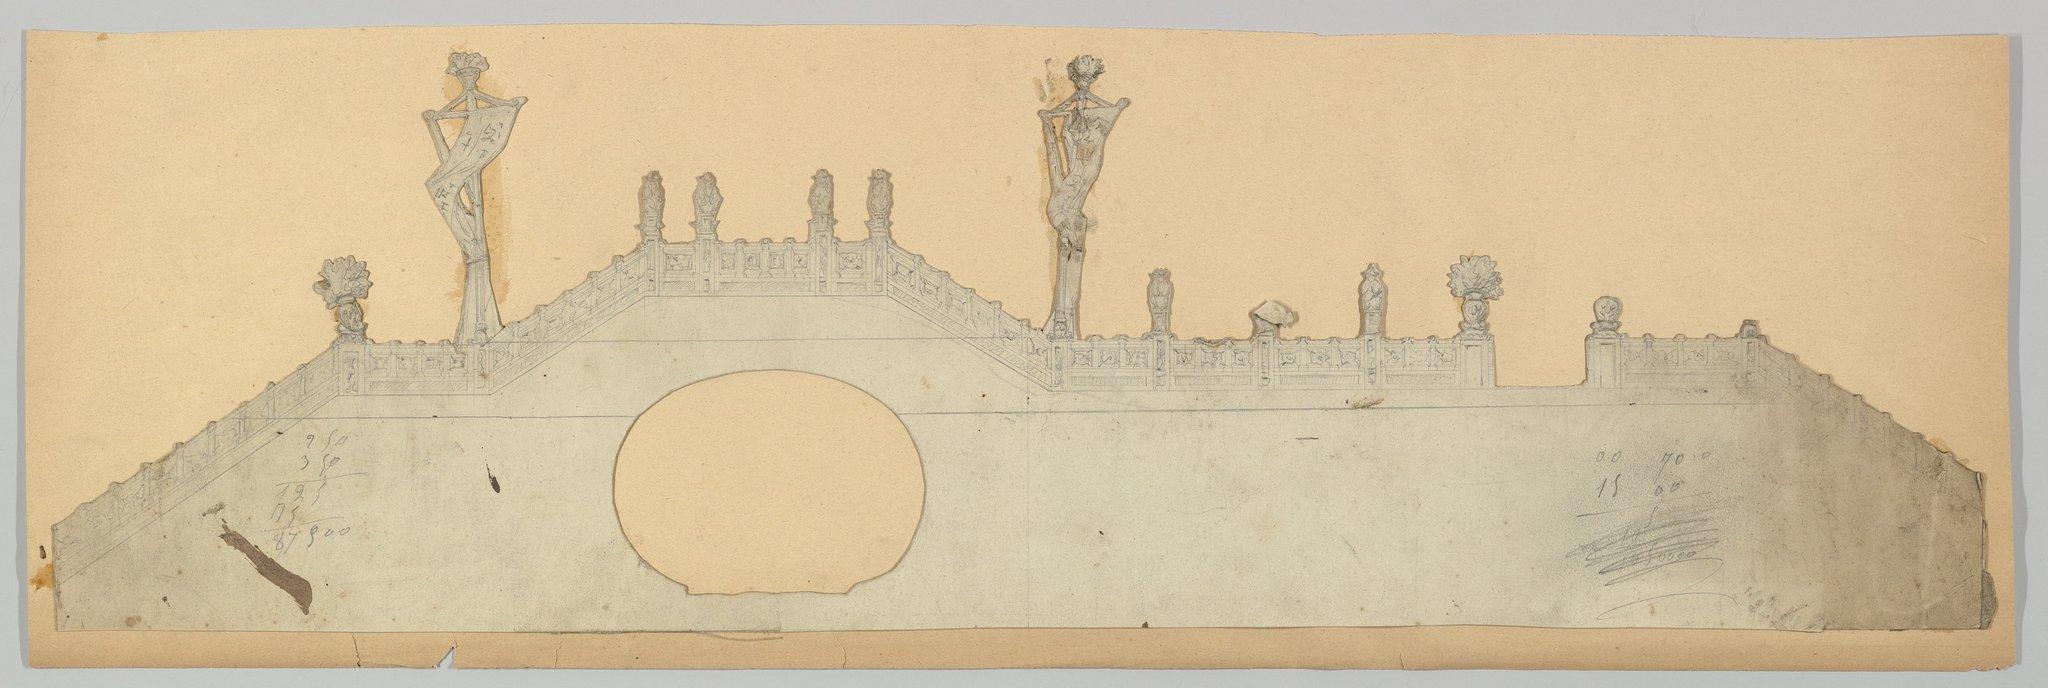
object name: drawing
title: Design for a Stage Set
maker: eugène cicéri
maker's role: artist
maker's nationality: french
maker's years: 1813-1890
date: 1830-1890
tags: stage design